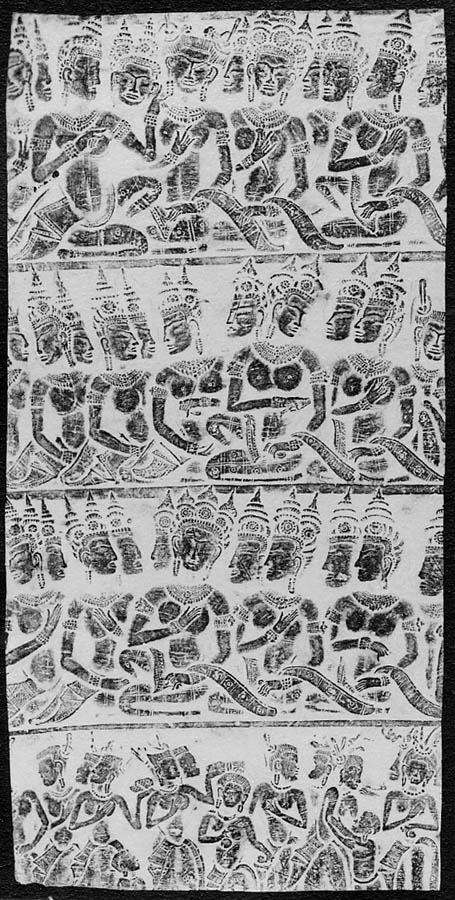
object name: rubbing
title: Rubbing of Apsarases (Dancers)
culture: cambodian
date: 1901-2000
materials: ink, paper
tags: women,dancers